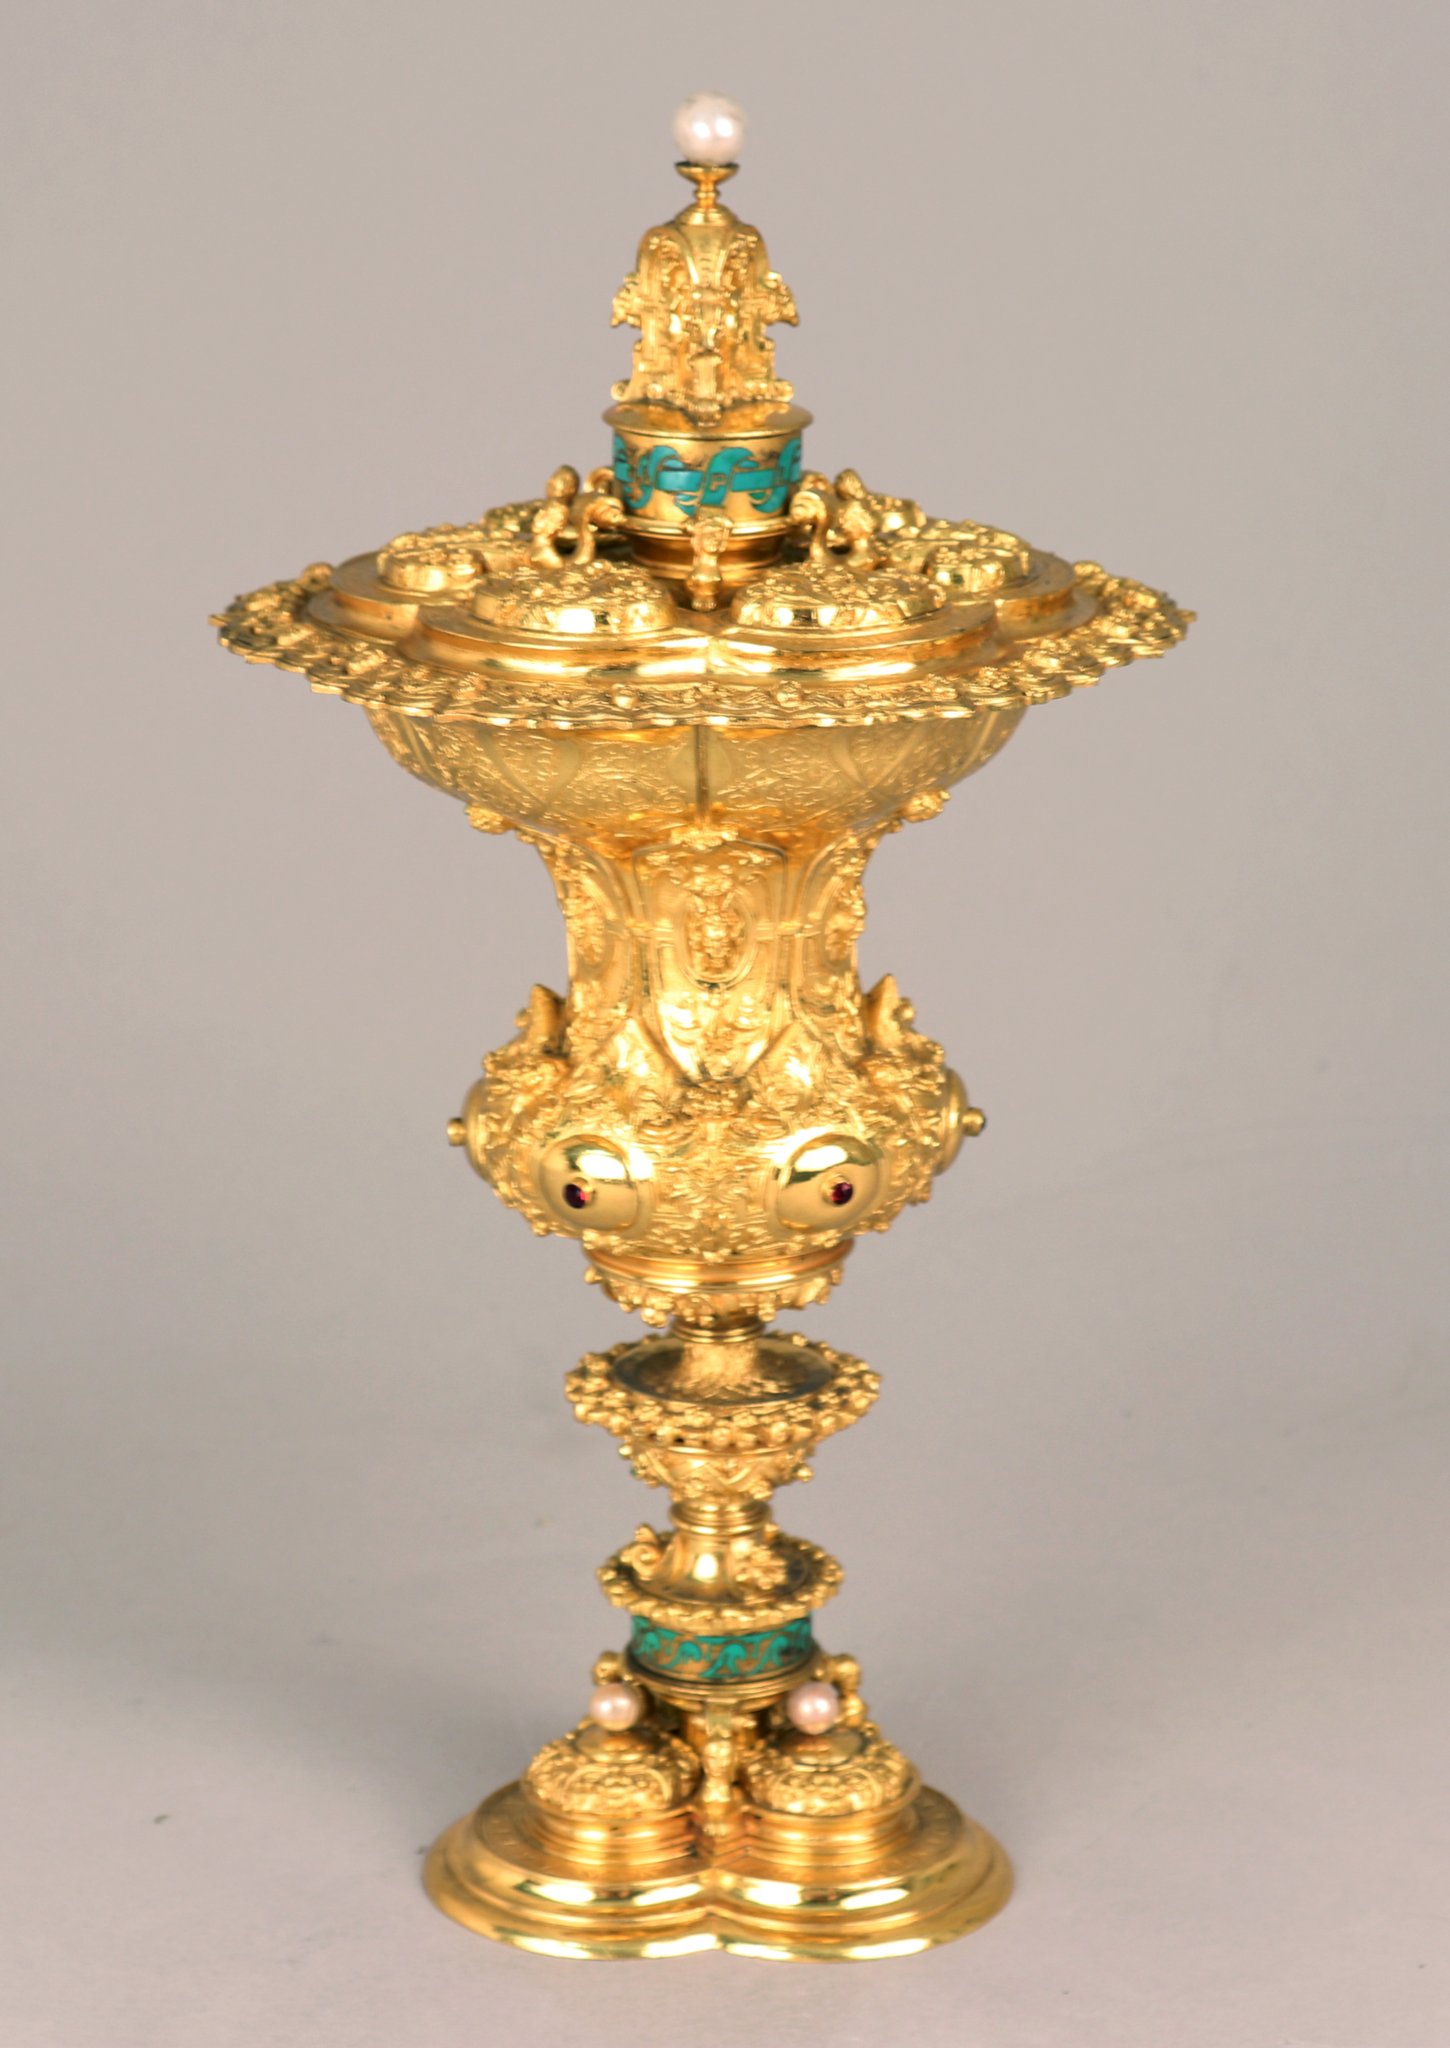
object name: cup with cover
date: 1801-1900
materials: metal, silver